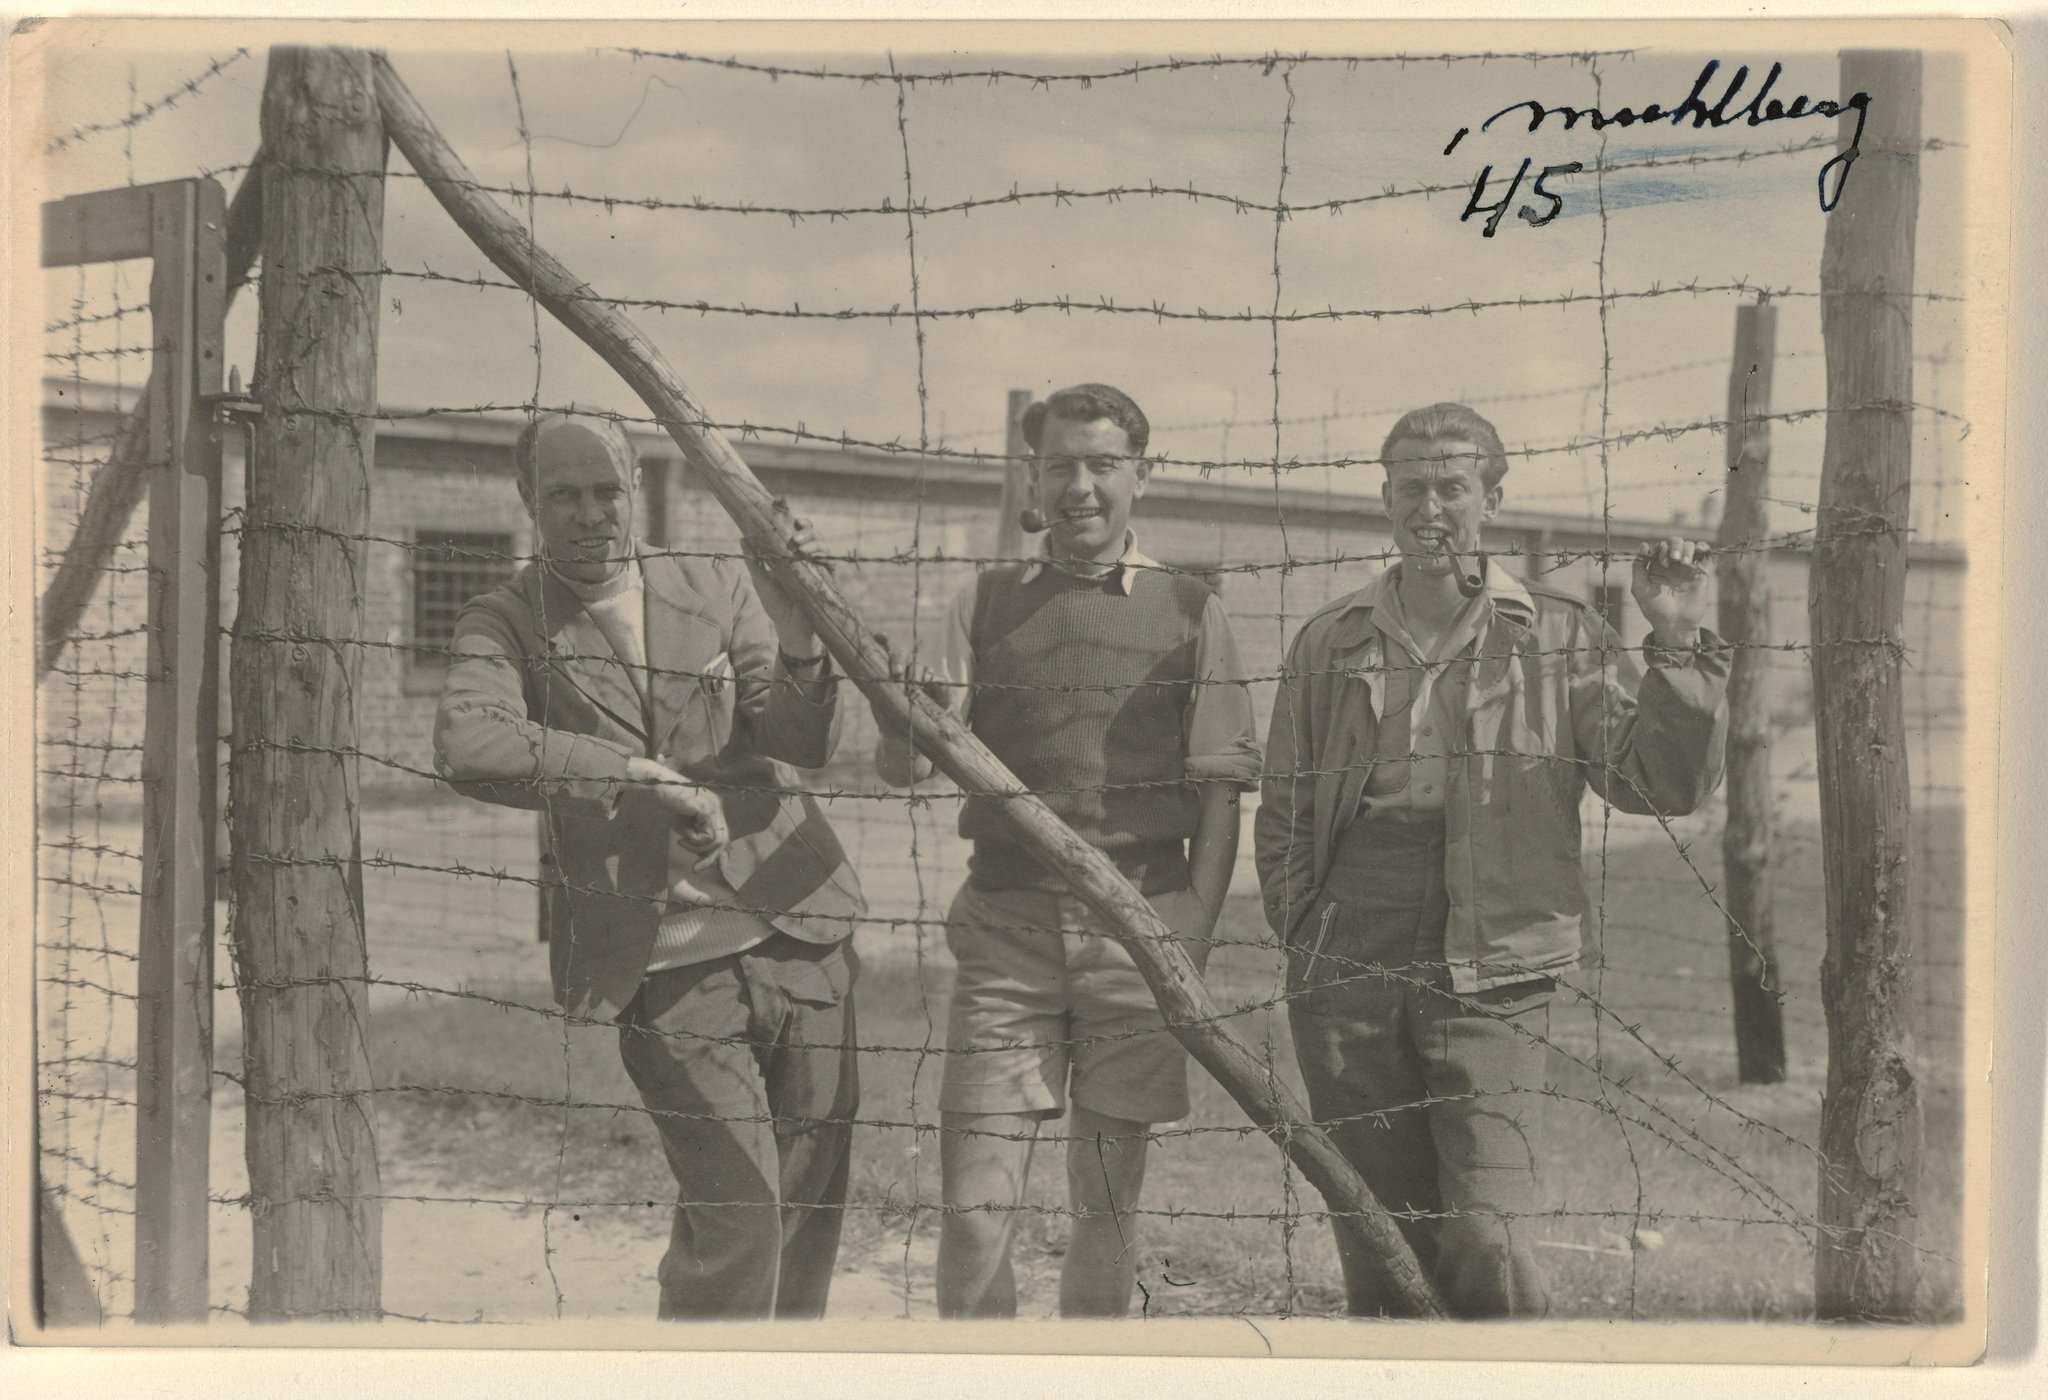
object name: photograph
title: Van Maarseveen en twee anderen in het bevrijde kamp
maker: dick w.b. van maarseveen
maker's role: fotograaf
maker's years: 1905-1990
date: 1945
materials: photographic support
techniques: gelatin silver print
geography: muhlberg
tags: the hague, dick w.b. van maarseveen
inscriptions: inscription: ‘muhlberg '45’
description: Fotograaf Van Maarseveen en twee andere gevangenen wachten op hun vertrek uit het bevrijde kamp. 1945. Zij poseren achter een prikkeldraadversperring. Onderdeel van een groep foto's gemaakt door Dick van Maarseveen in het Duitse krijgsgevangenenkamp Stalag IV B in Mühlberg in de periode 1943-1945.